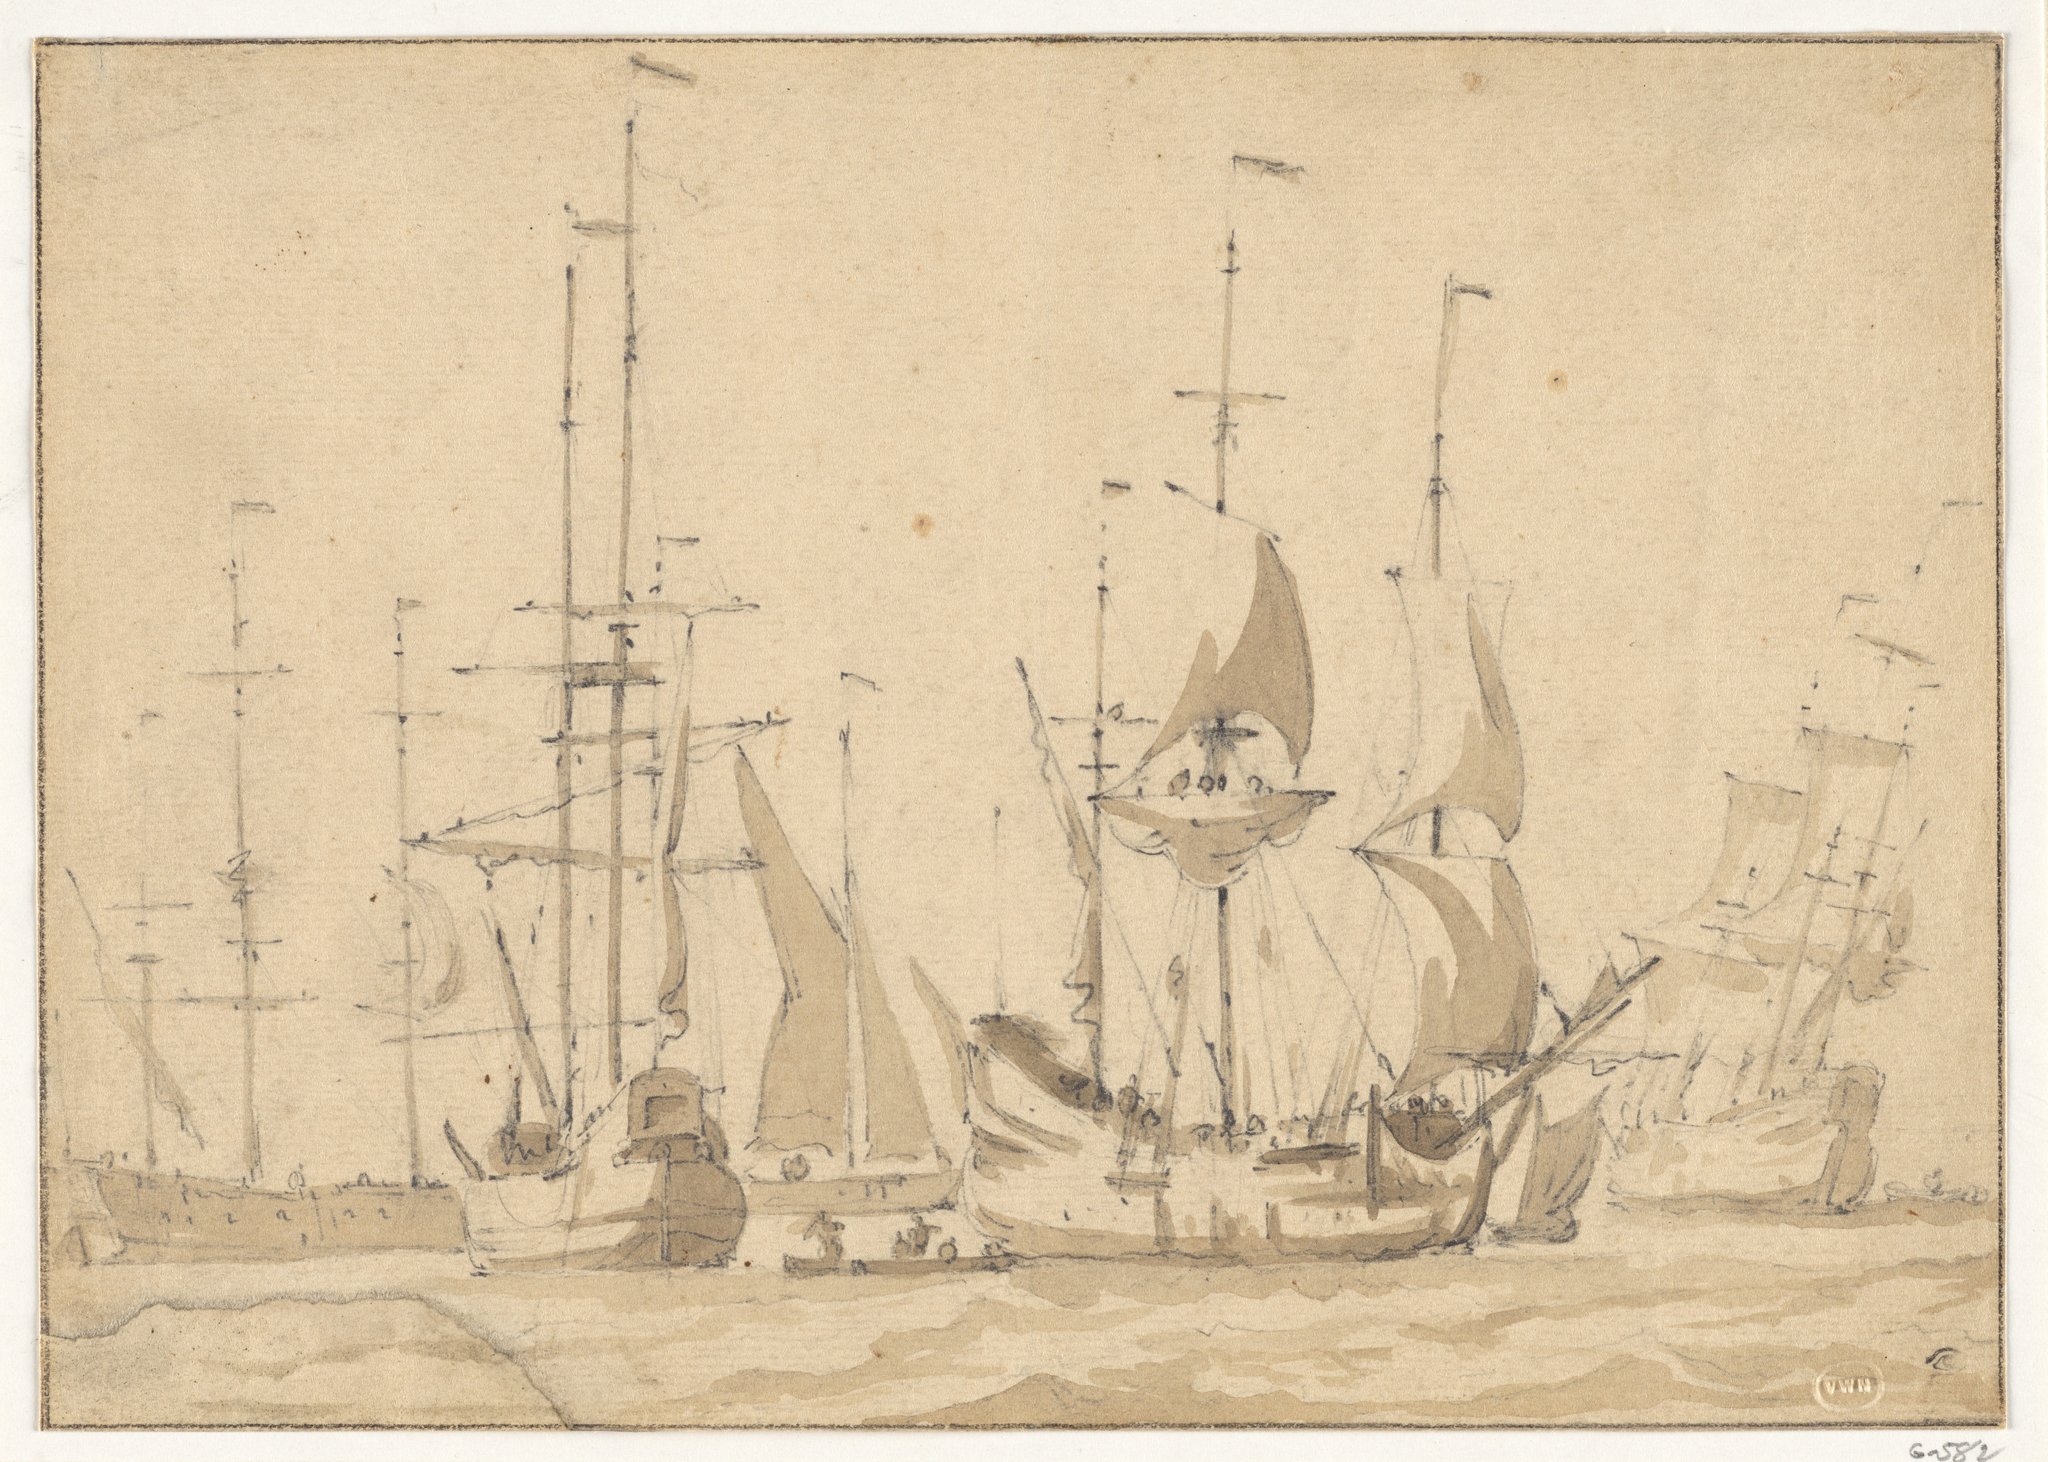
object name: drawing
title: Dutch Merchant Ships at Anchor or under Easy Sail in a Moderate Breeze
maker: willem van de velde (i)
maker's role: artist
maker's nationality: dutch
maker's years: 1611-1693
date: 1658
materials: pencil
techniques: brush, wash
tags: ships